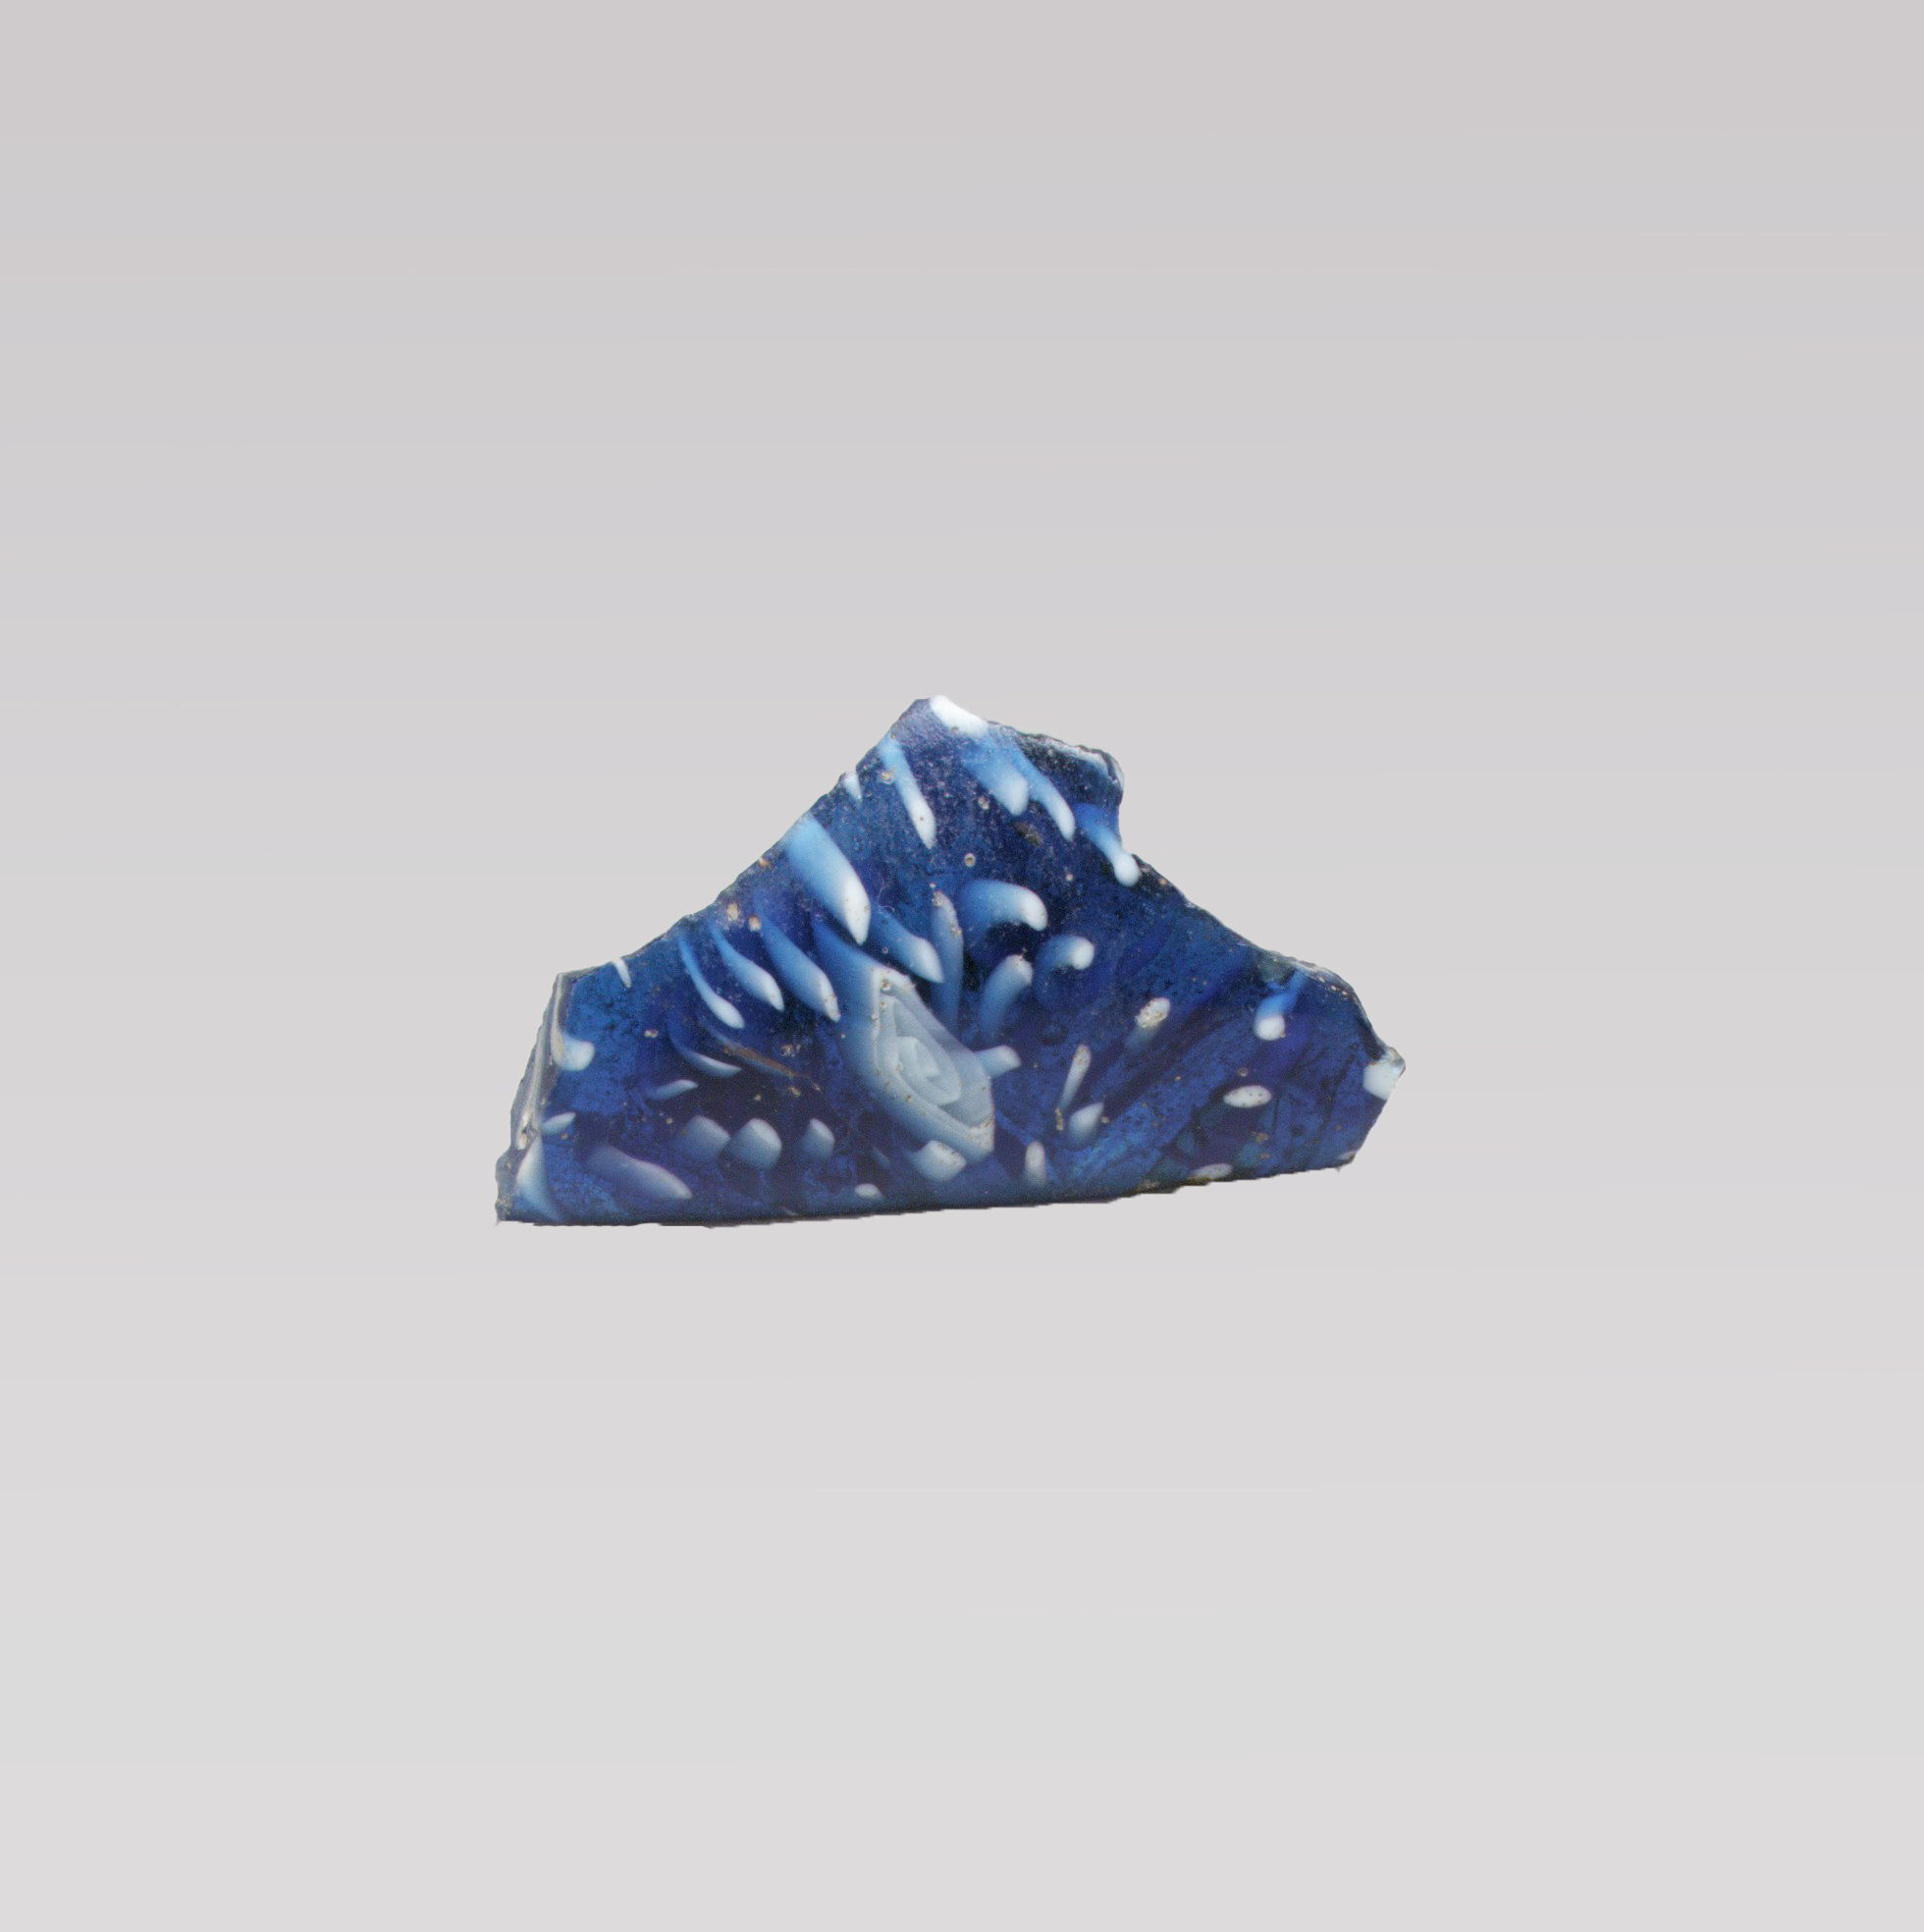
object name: fragment, mosaic dish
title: Glass mosaic dish fragment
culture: roman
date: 34 BCE-33 CE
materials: glass